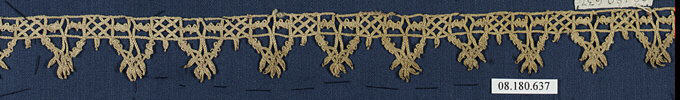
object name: fragment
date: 1601-1700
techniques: lace